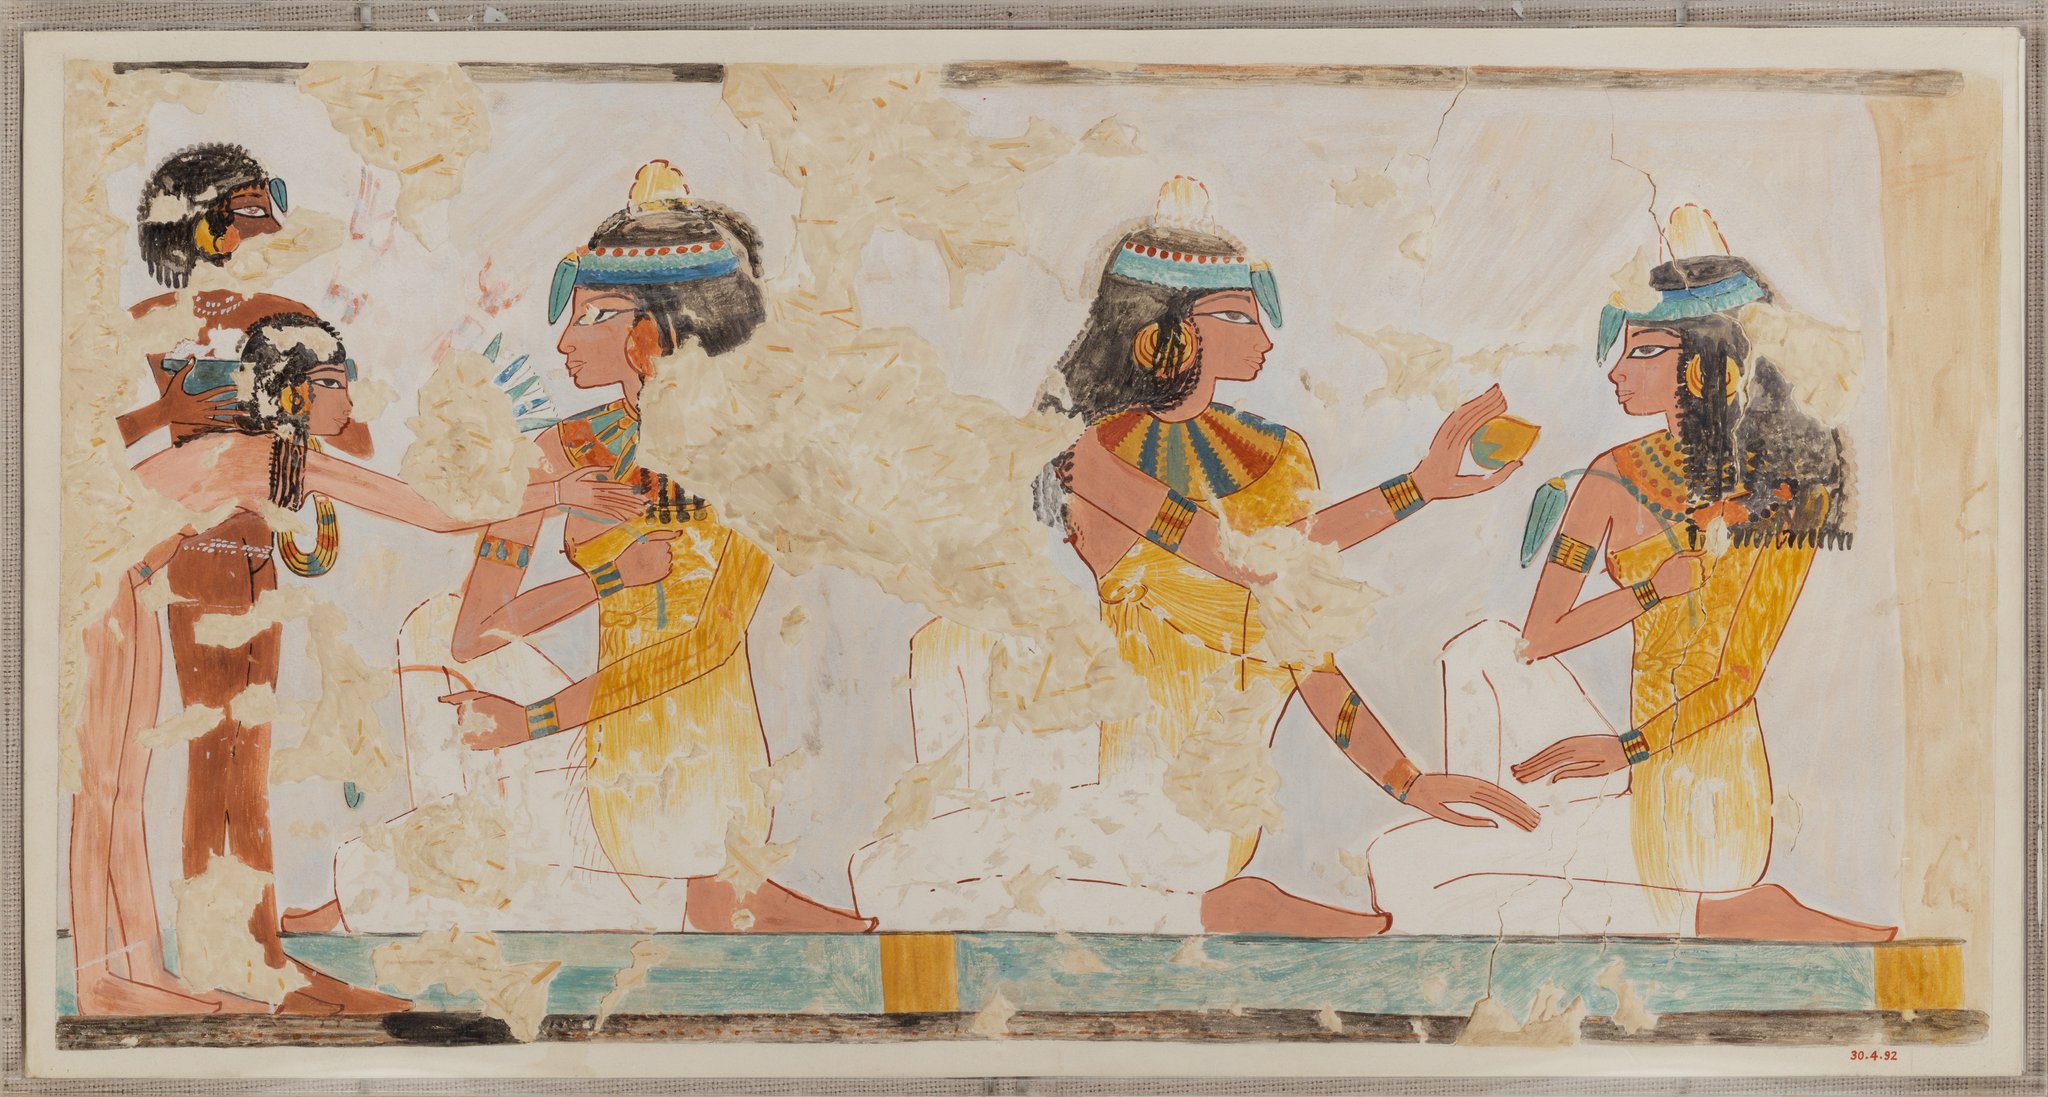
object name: facsimile, nebseny tt 108, banquet guest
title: Women at a Banquet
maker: nina de garis davies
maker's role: artist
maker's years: 1881-1965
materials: paper, paint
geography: egypt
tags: women,drink-and-be-merry